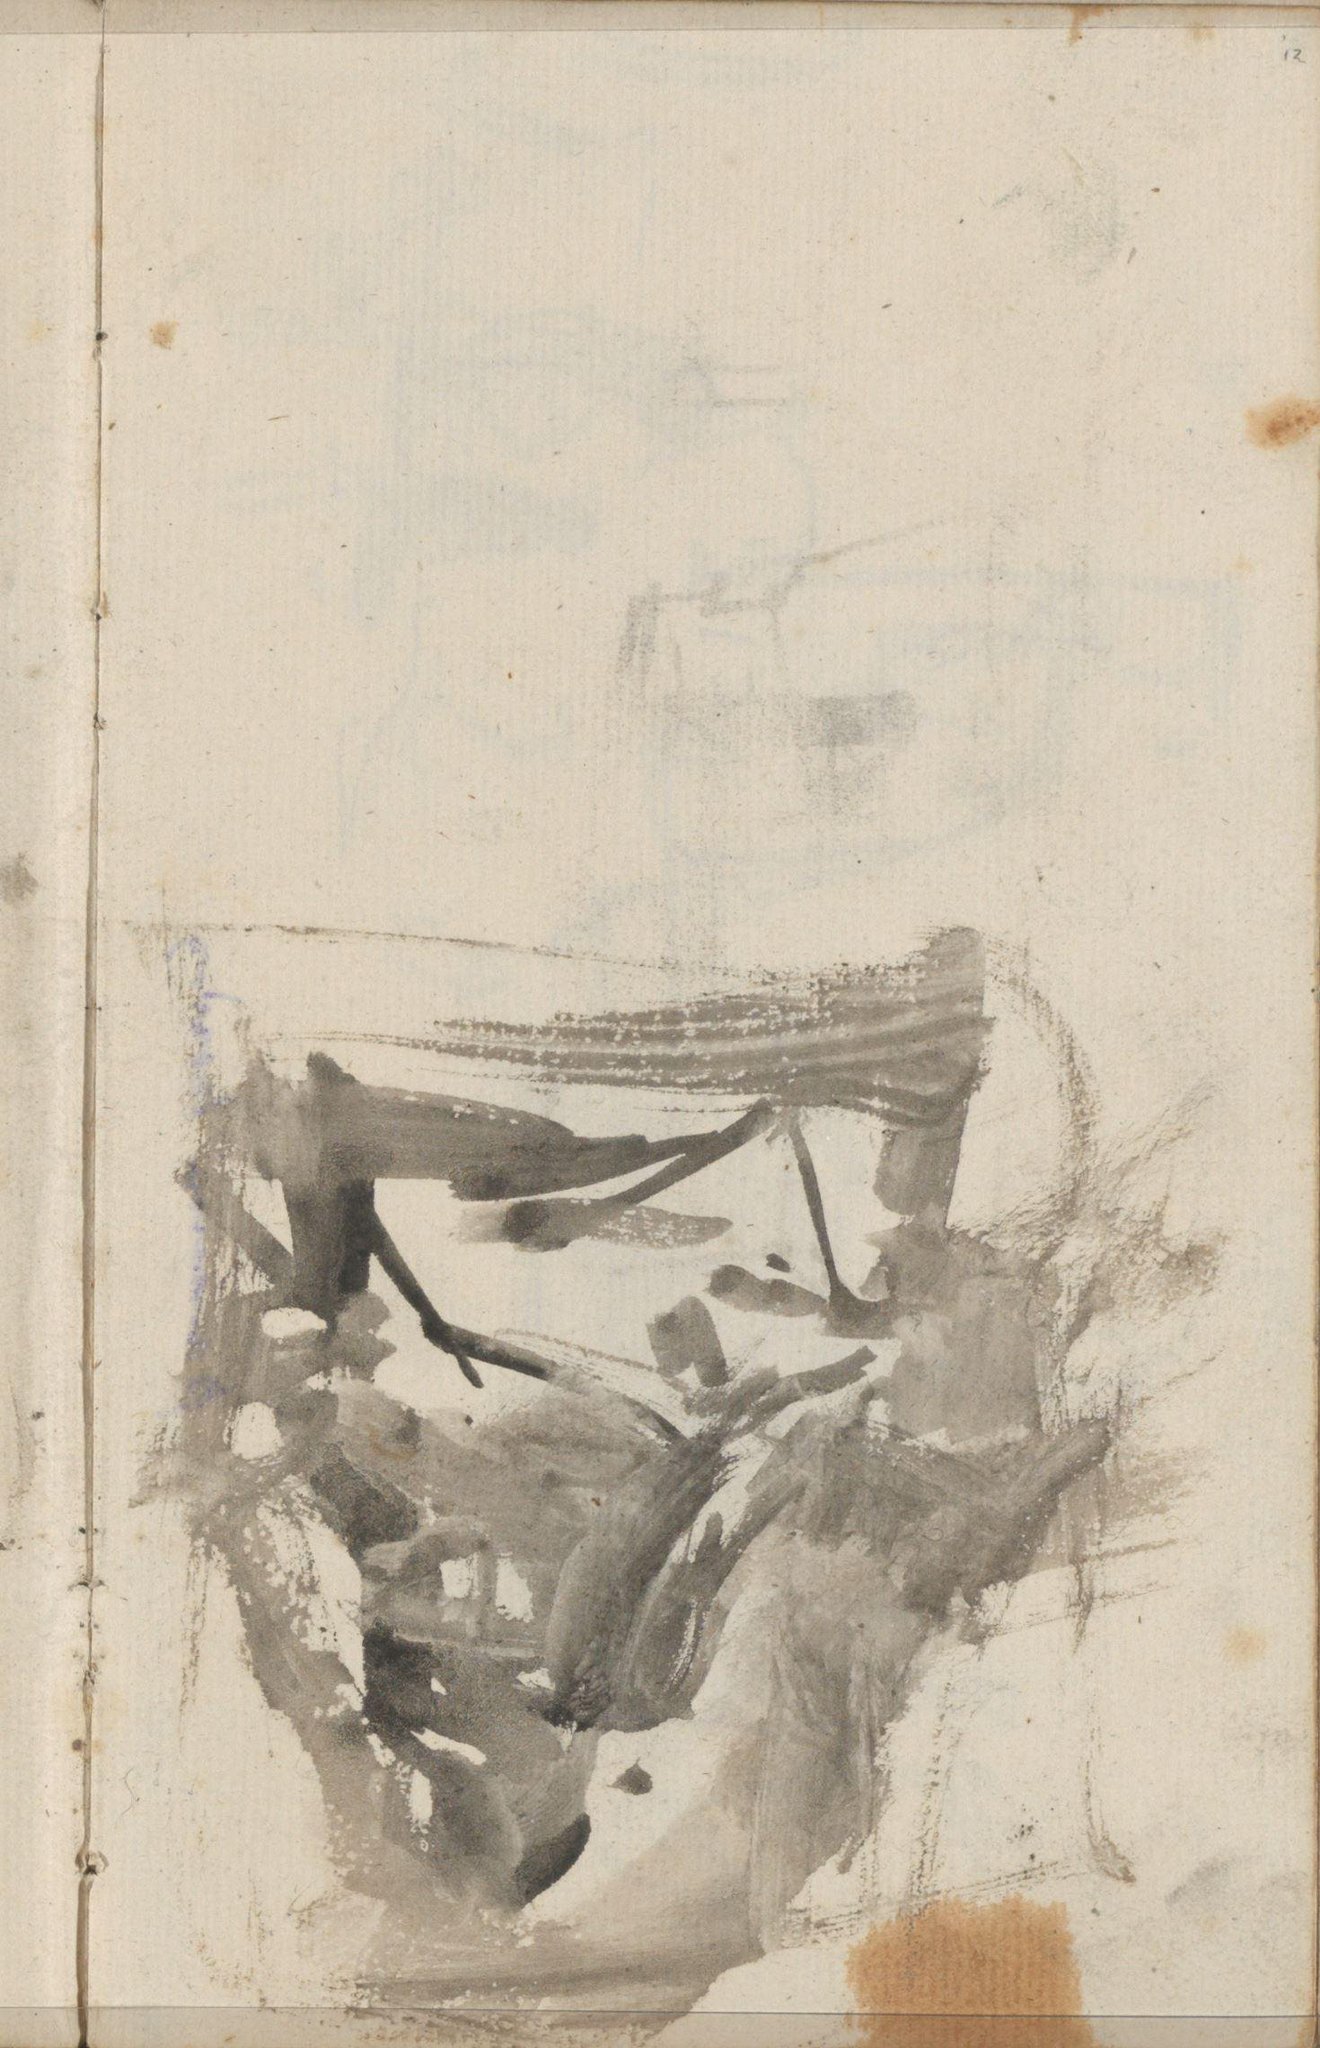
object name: sketchbook leaf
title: Studie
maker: george hendrik breitner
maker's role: draughtsman, painter, print maker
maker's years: 1857-1923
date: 1880-1882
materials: paper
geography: scheveningen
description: Pagina 12 uit een schetsboek met 31 bladen.